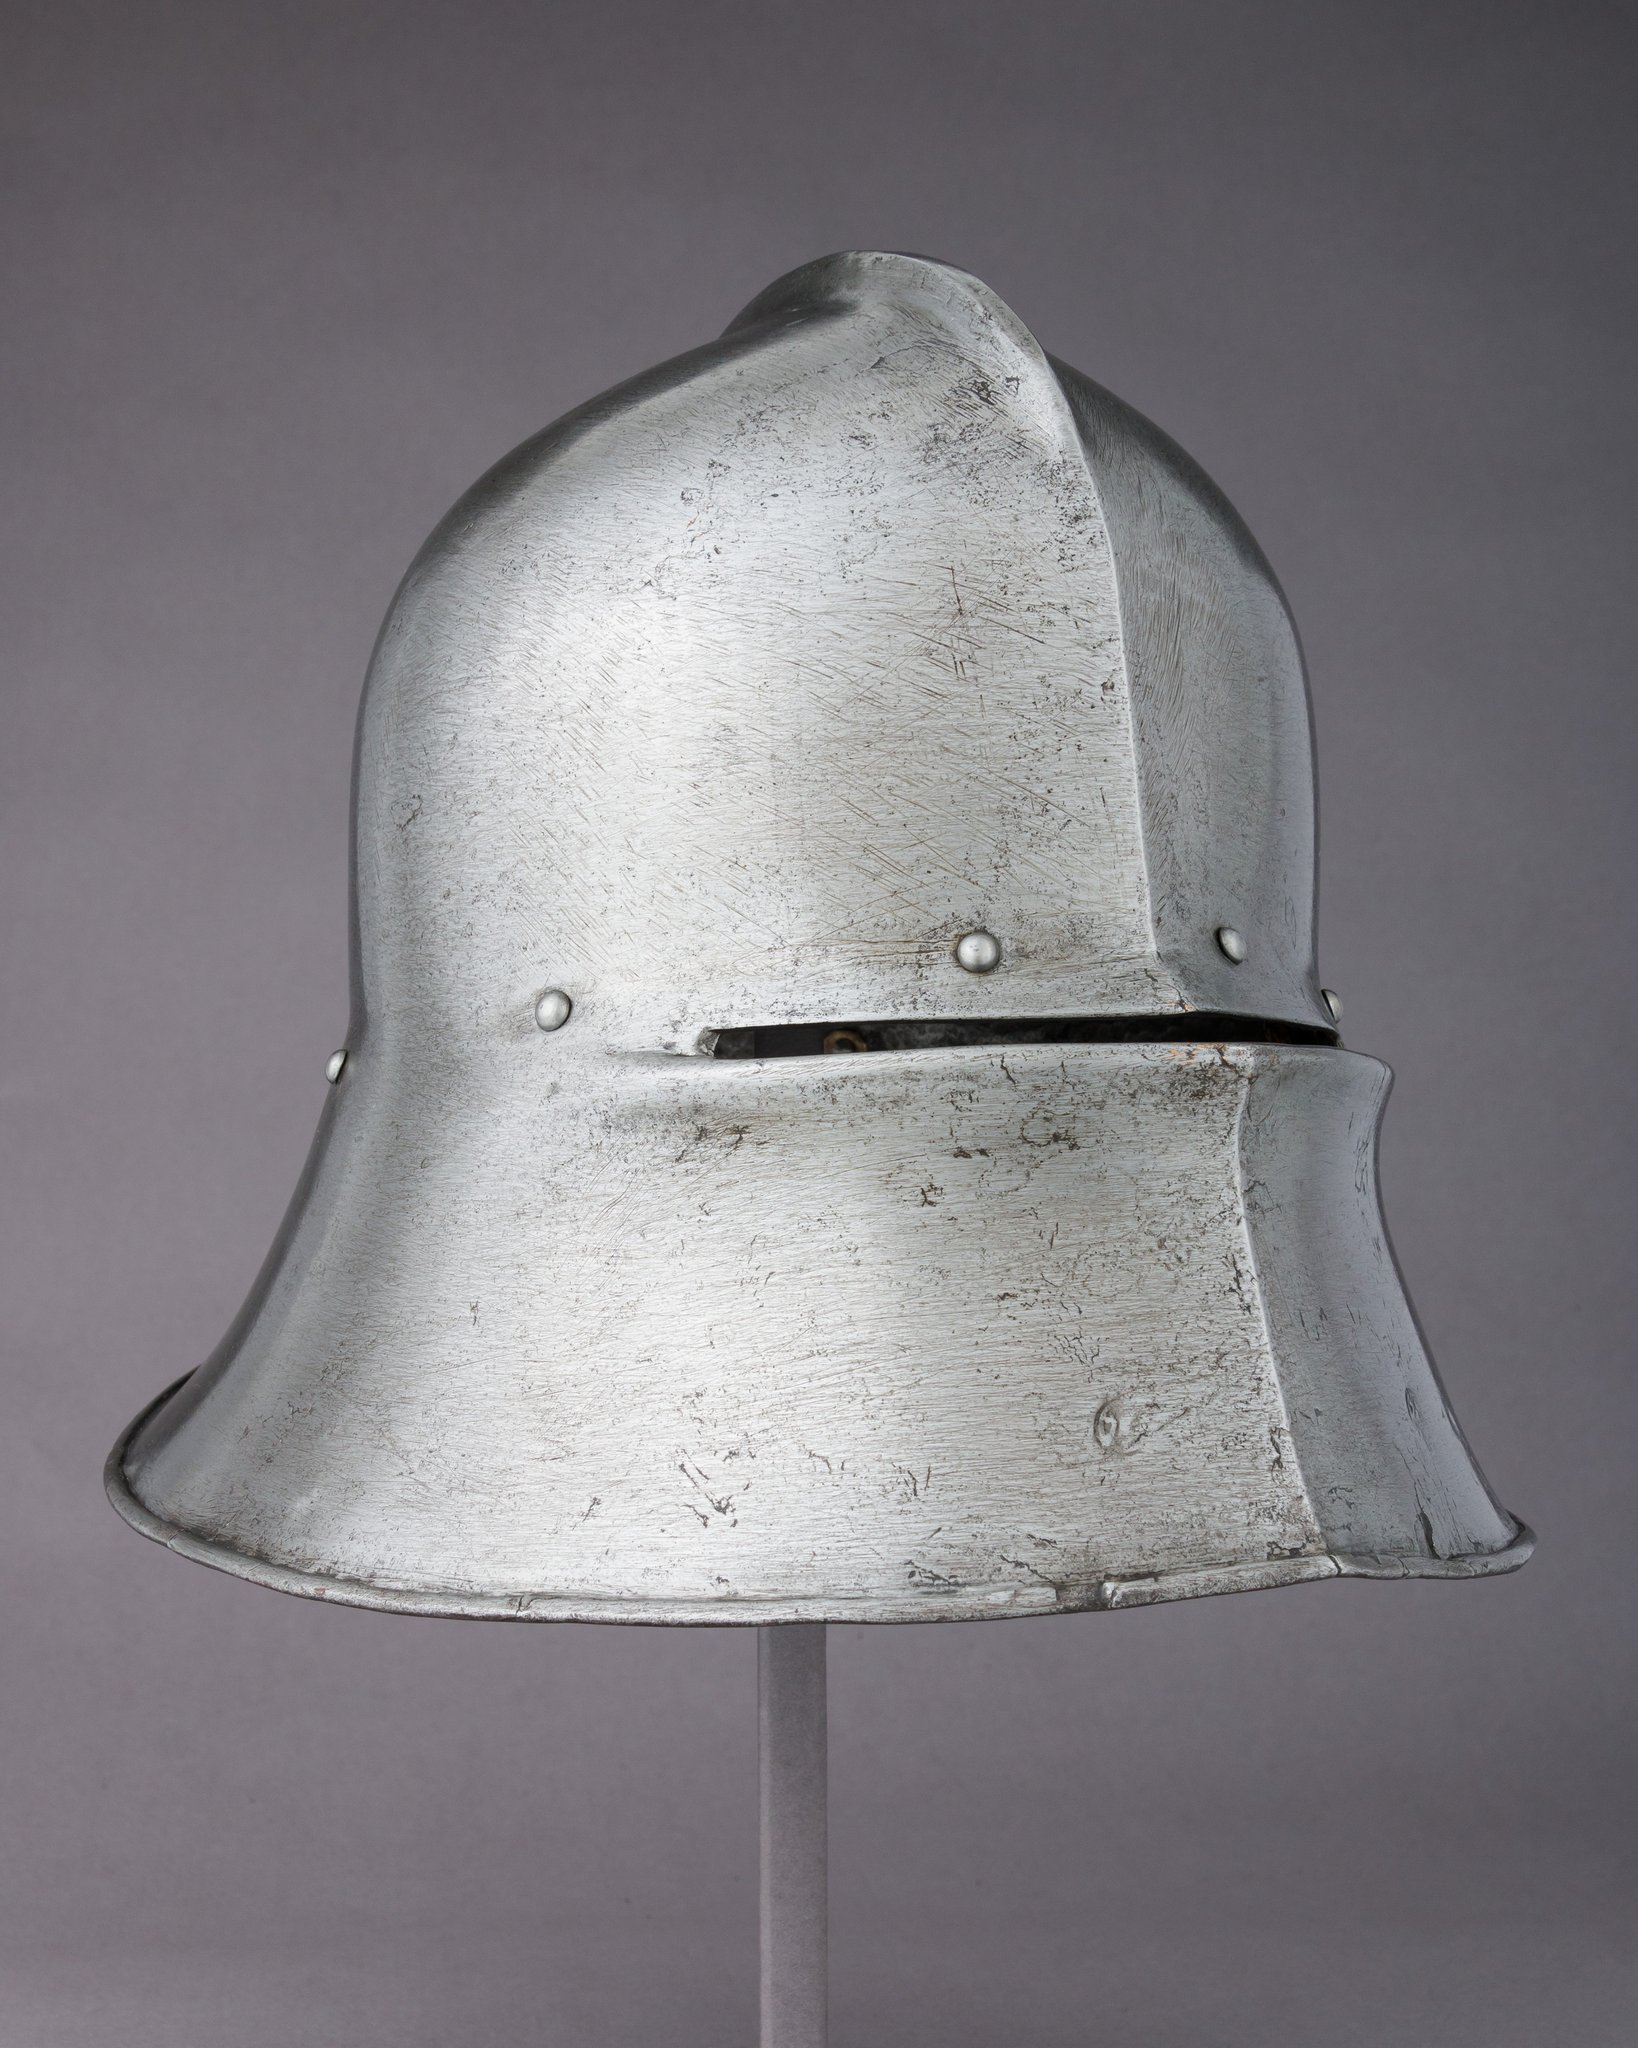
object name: sallet and bevor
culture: german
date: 1480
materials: copper alloy, leather, steel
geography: germany